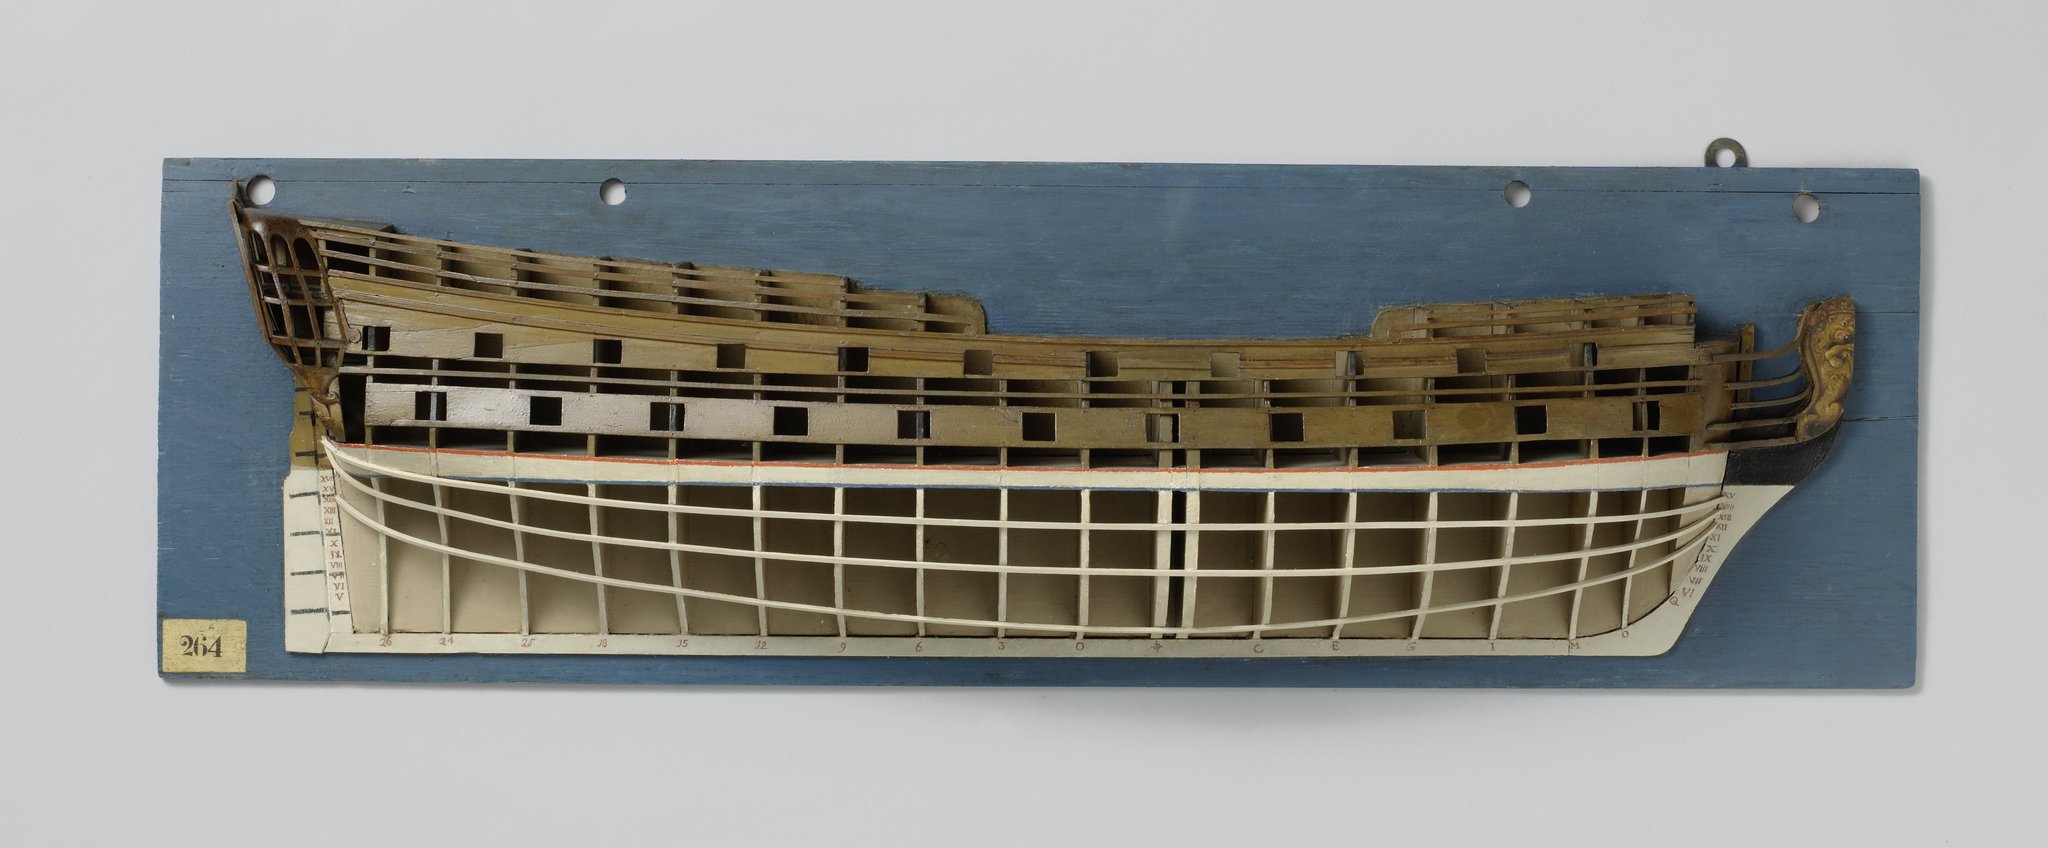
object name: half model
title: Half model of a 54-gun ship of the line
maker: Anonymous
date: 1730-1780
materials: wood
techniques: polychromy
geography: netherlands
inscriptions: label, bottom left: ‘264’ former inventory label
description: Het onderbreken van barkhouten en reehout door de poorten wijst op een wat ouder ontwerp.